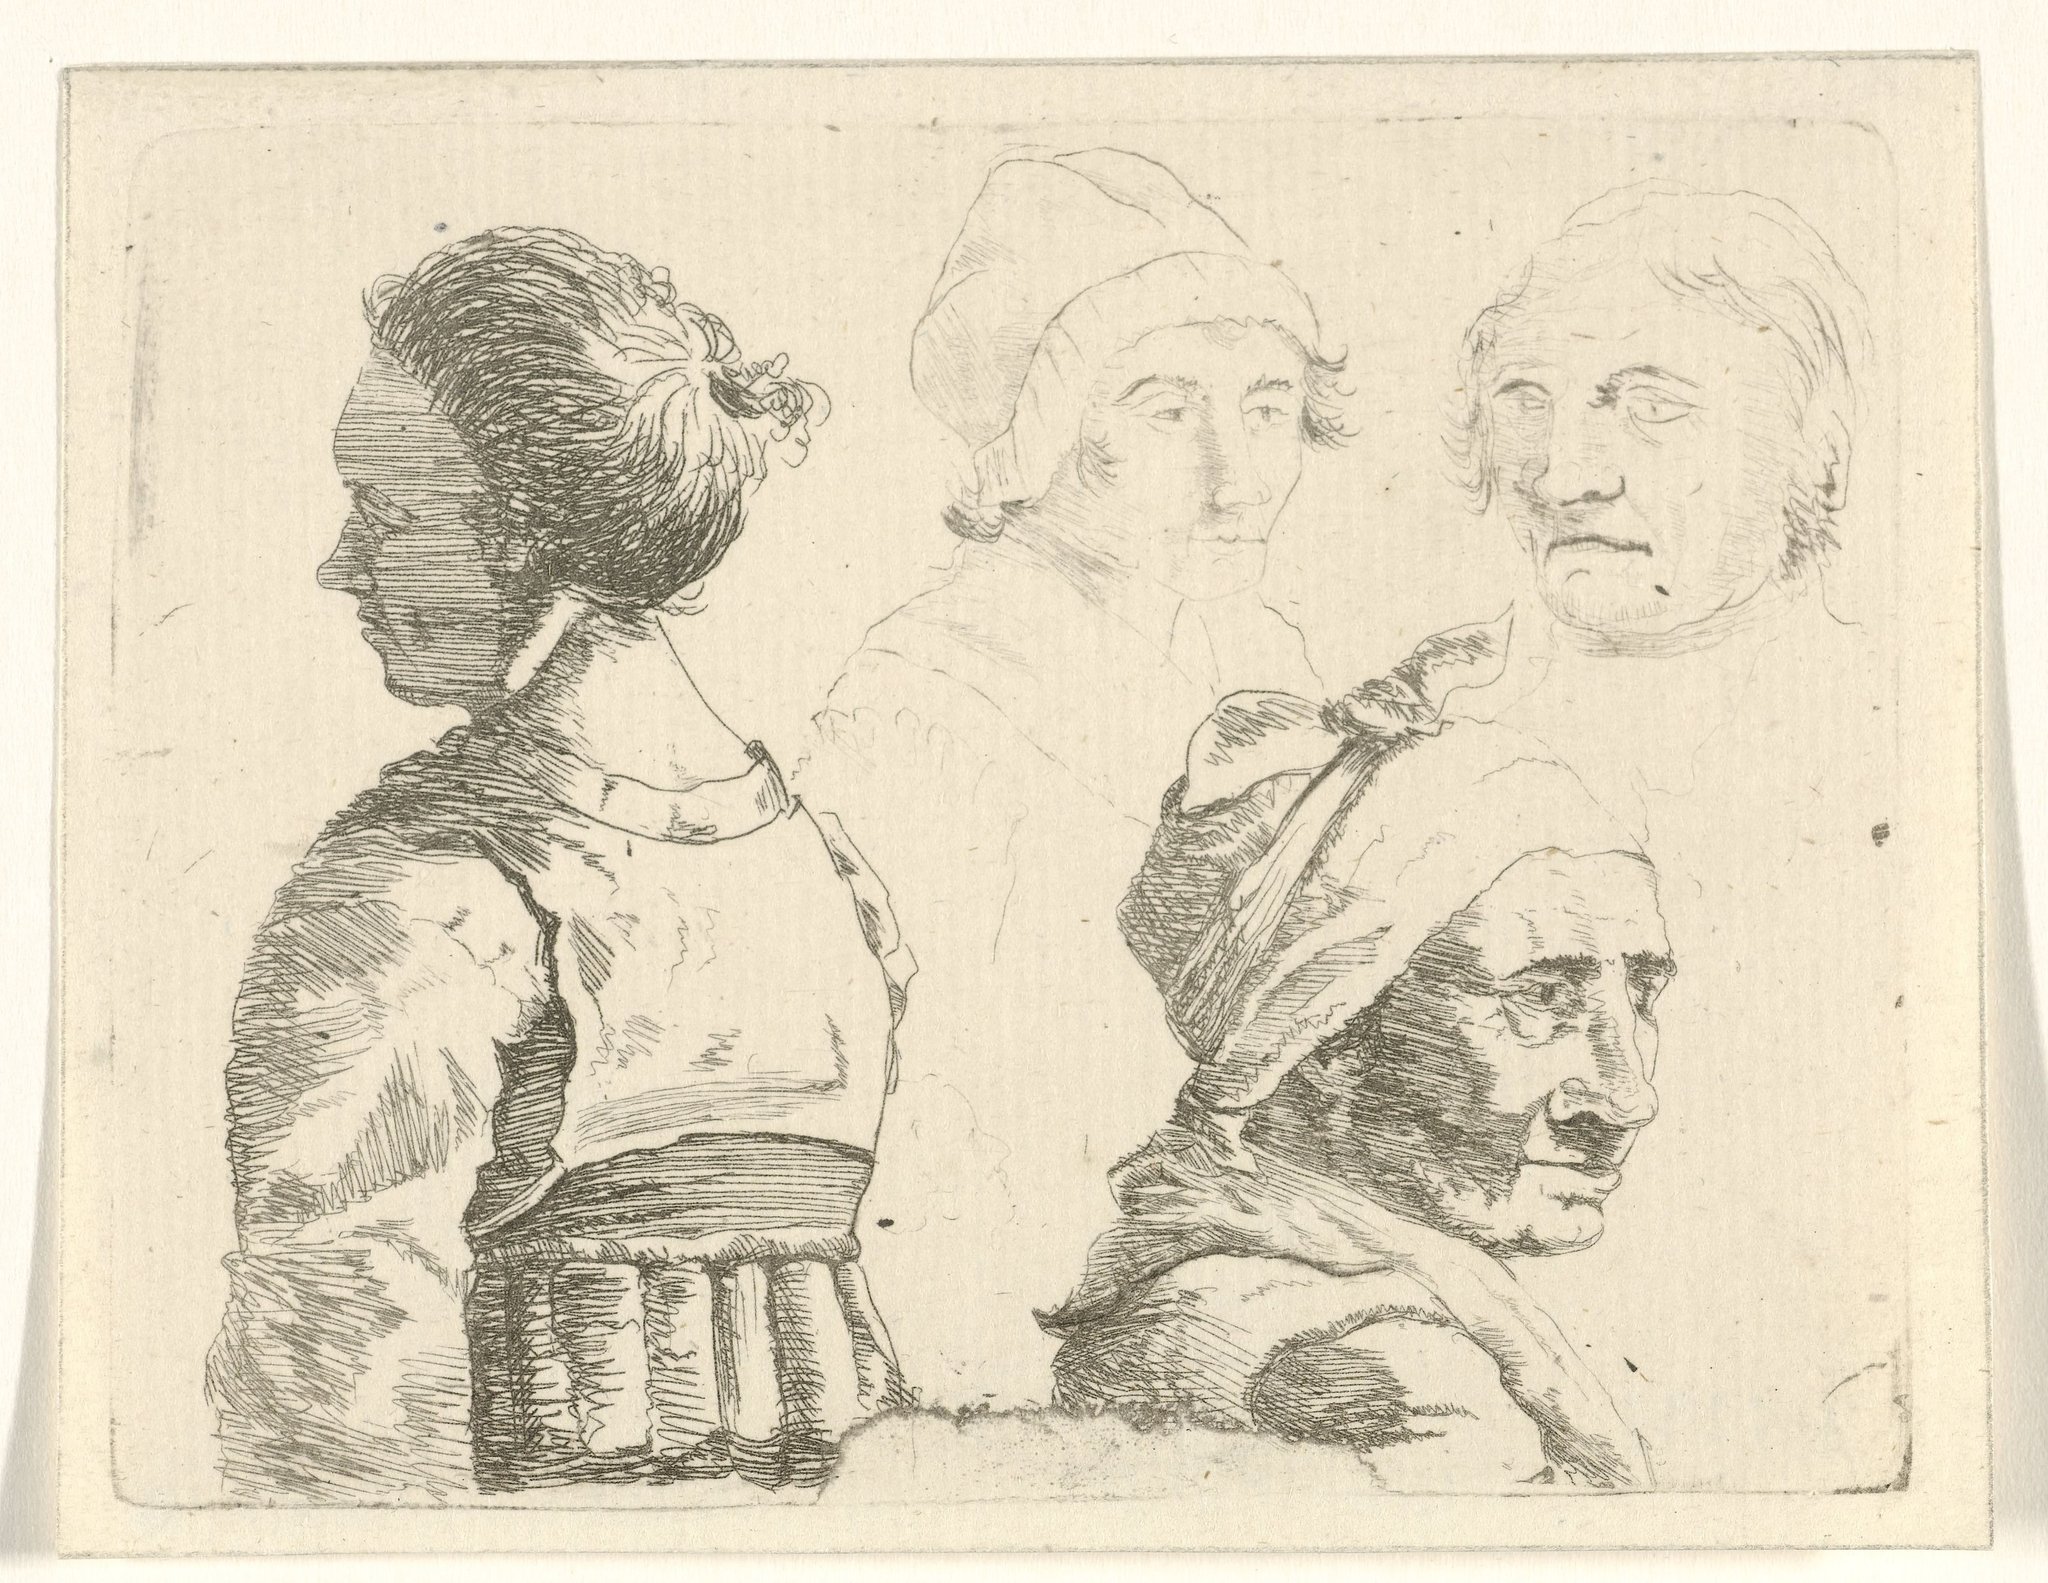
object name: print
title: Studieblad met een vrouwenbuste en drie vrouwenhoofden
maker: gerrit lamberts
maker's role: bookseller, draughtsman, print maker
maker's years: 1776-1850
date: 1810-1850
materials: paper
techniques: etching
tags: female sex; woman, head (human) - aa - female human figure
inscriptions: collector's mark: Lugt 2228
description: Studieblad met links een buste van een vrouw, op de rug gezien en met het gelaat en profil. Rechts drie vrouwenhoofden.